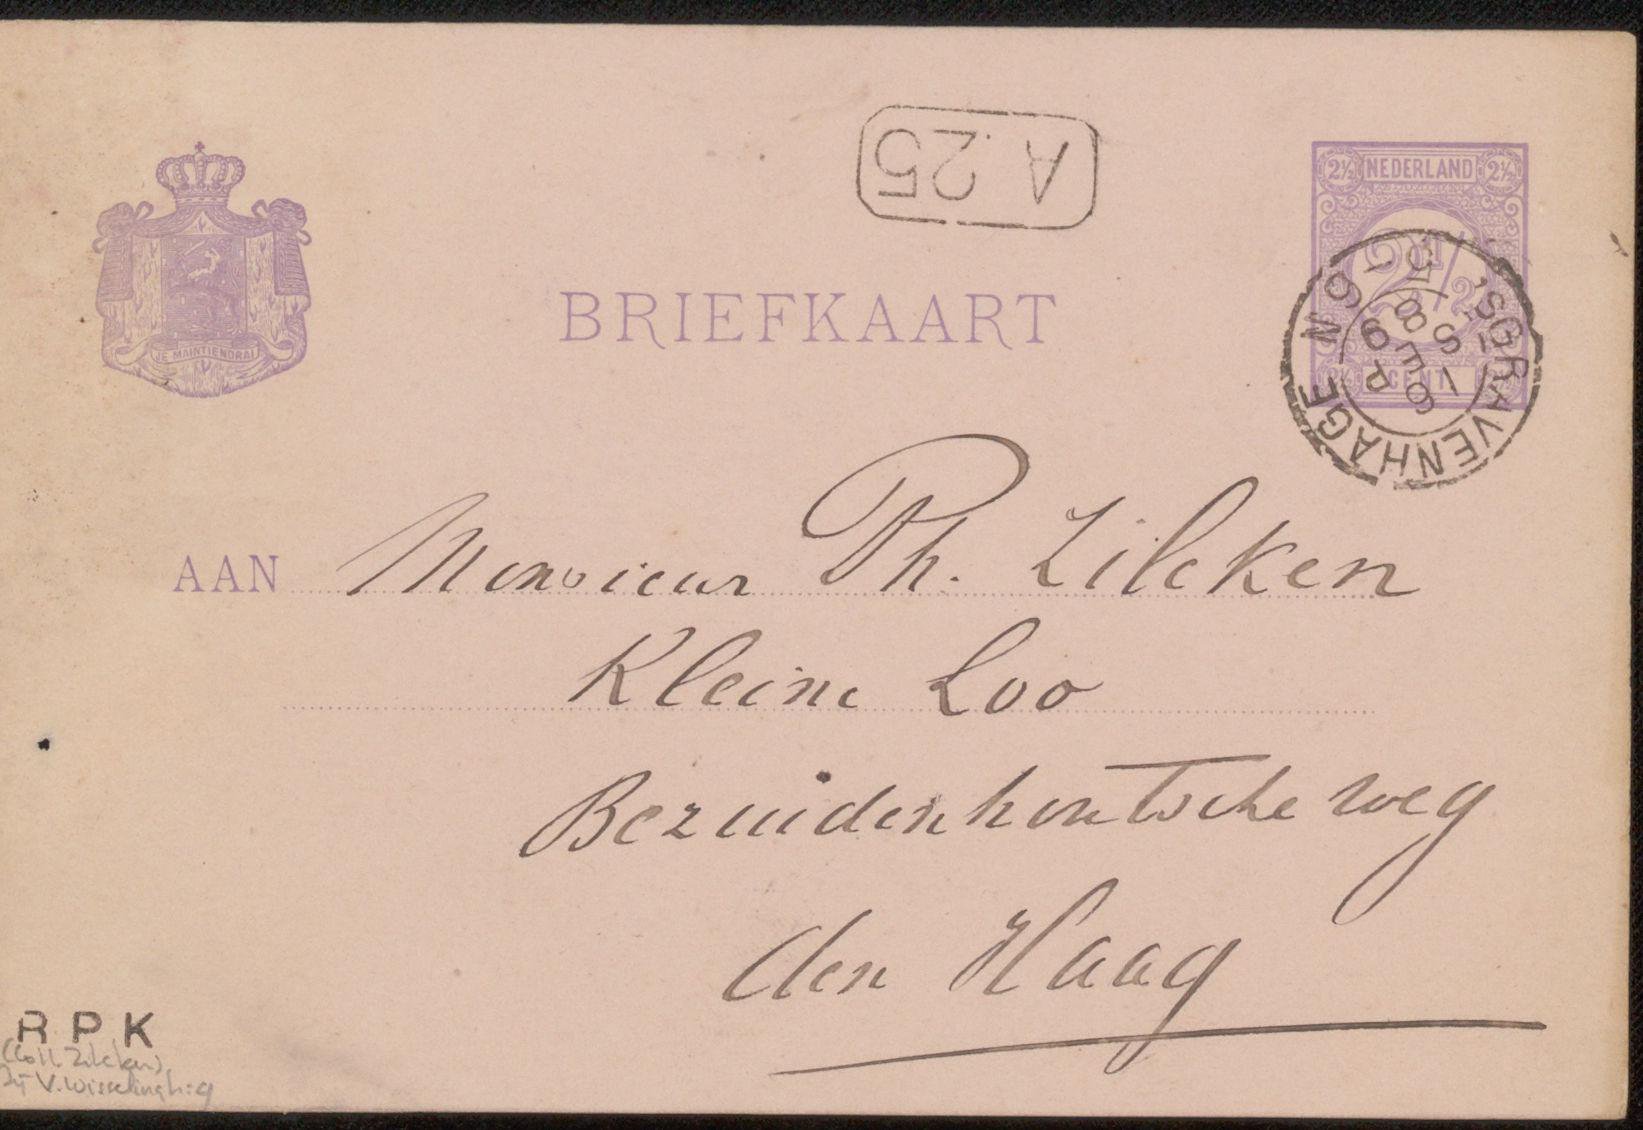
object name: postcard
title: Briefkaart aan Philip Zilcken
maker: elbert jan van wisselingh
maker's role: kunsthandelaar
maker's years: 1848-1912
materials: cardboard, ink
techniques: pen, writing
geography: the hague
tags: alphonse legros, jean françois millet, the hague, print maker, draughtsman, barbara elisabeth van houten, philip zilcken, the graphic arts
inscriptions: collector's mark: ‘RPK’